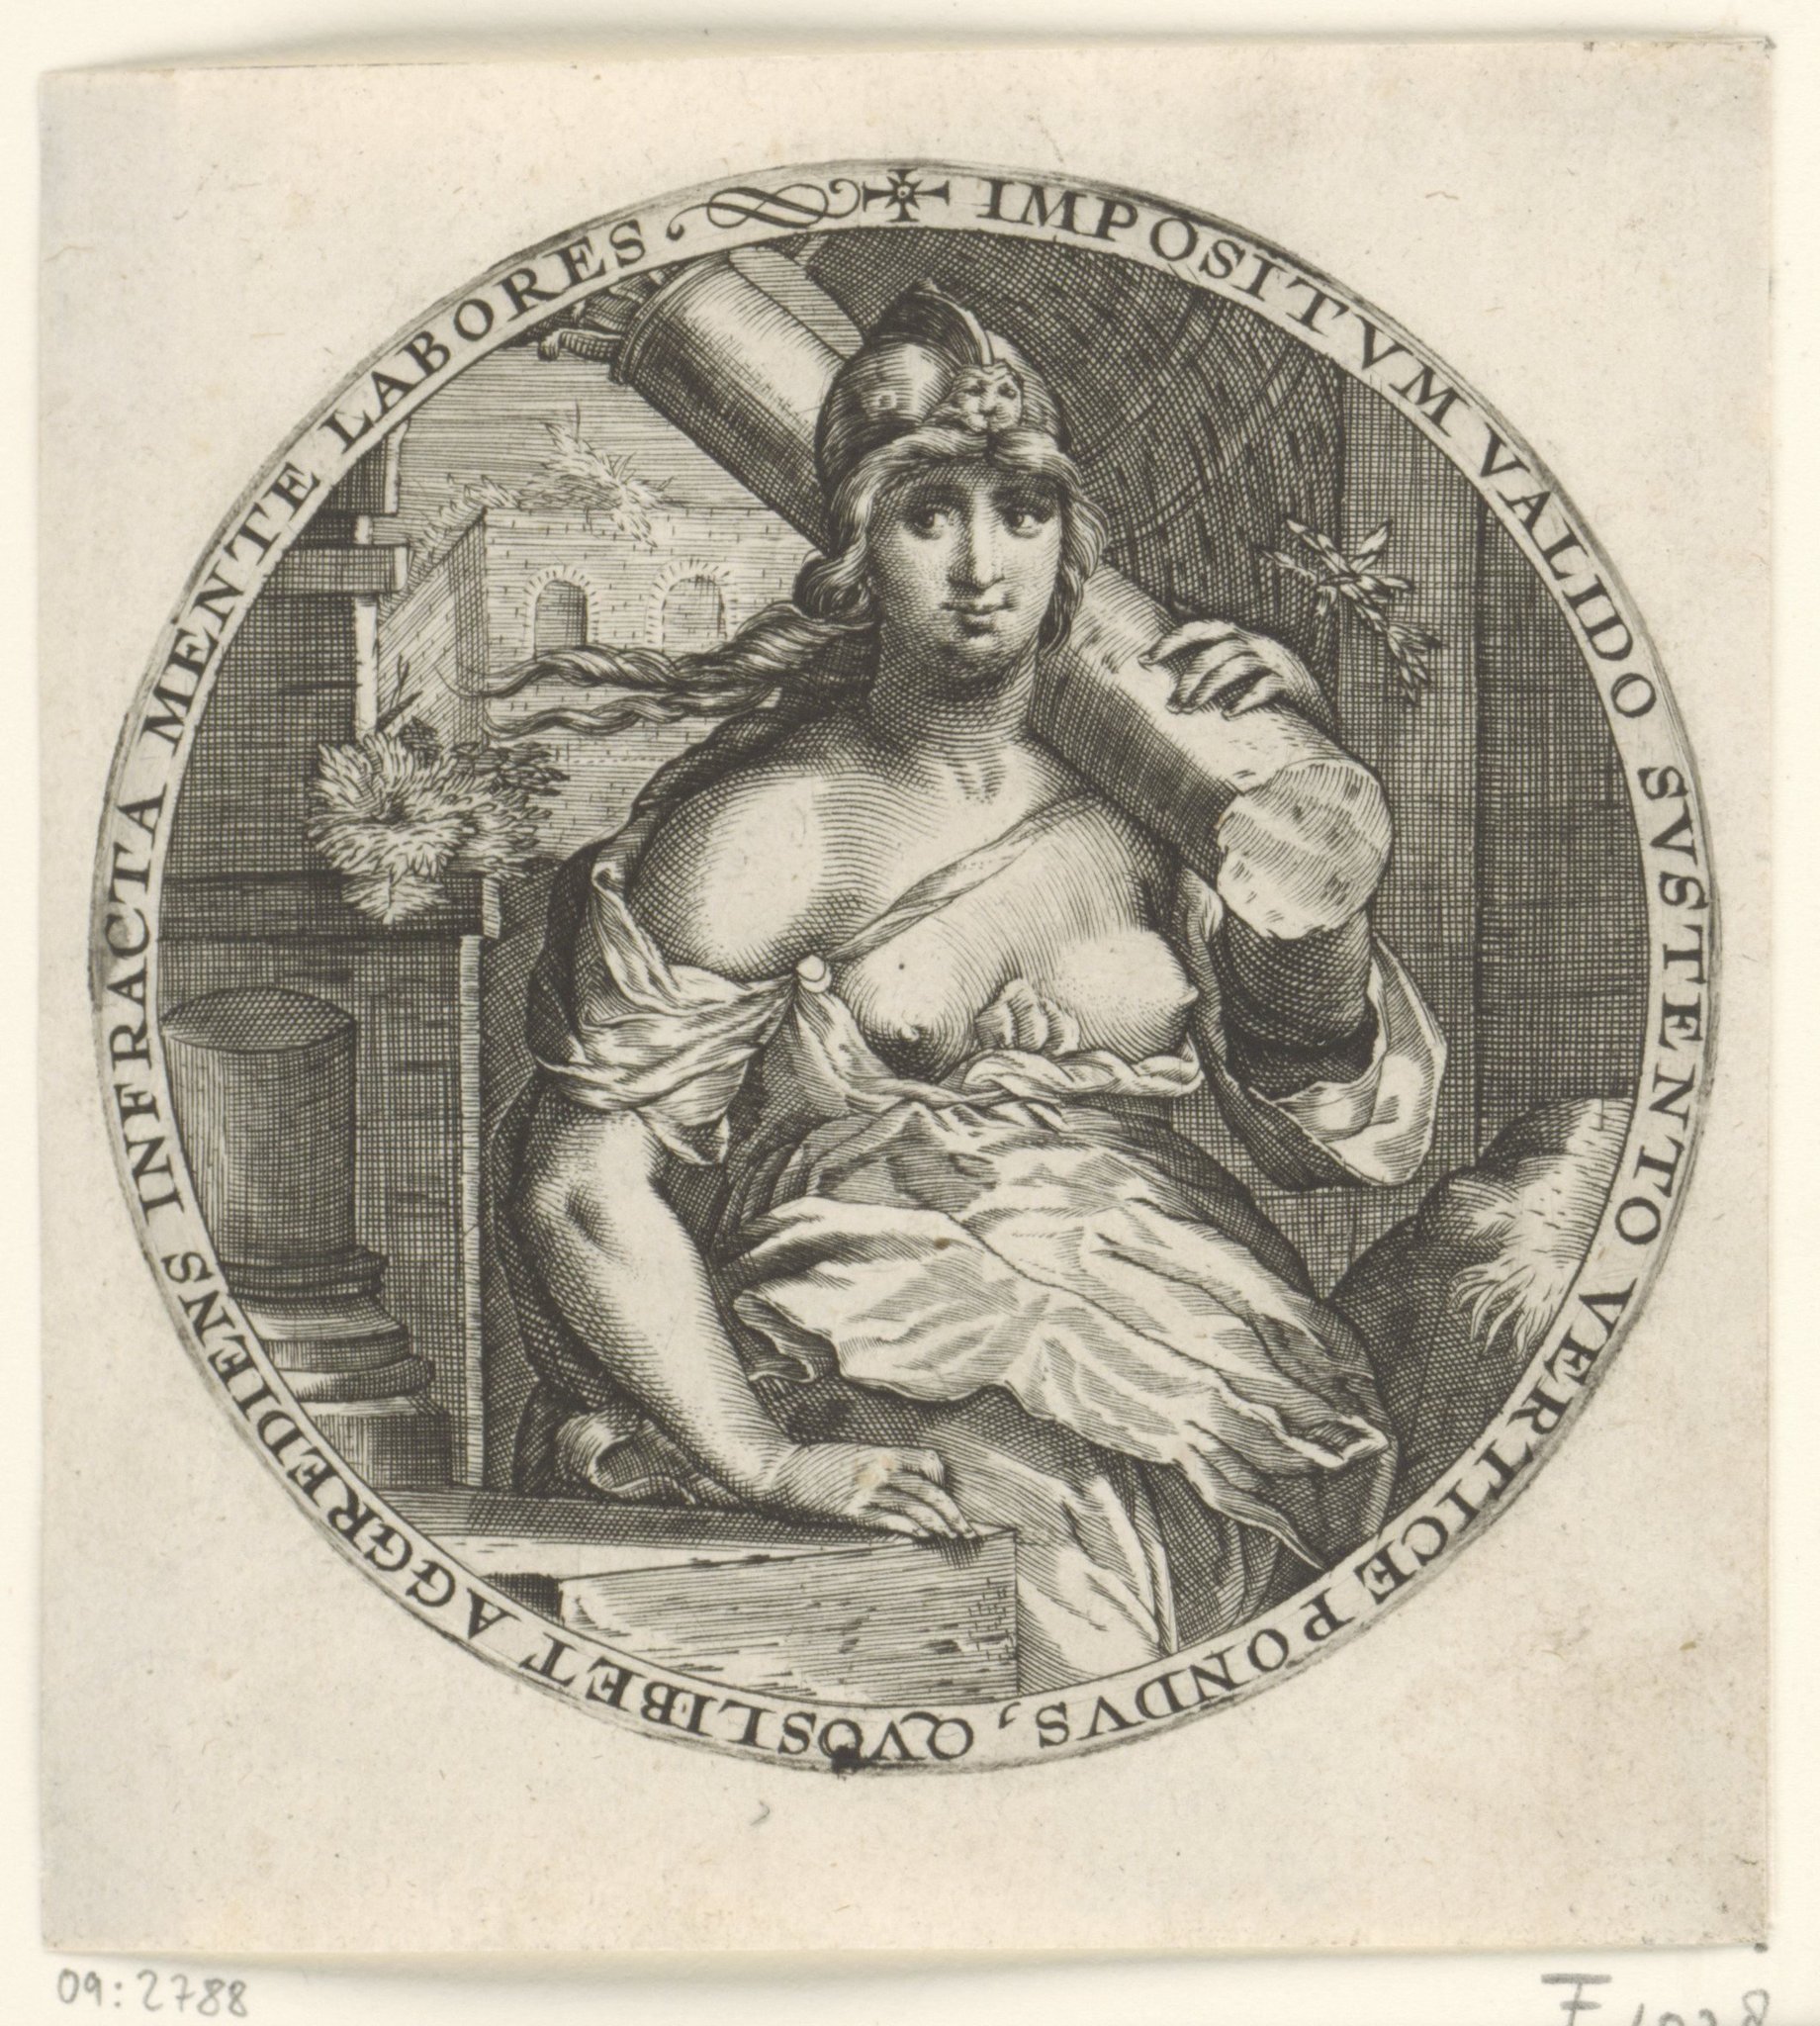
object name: print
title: Virtutu Theologicaru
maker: crispijn van de passe (i)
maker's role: draughtsman, print maker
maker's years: 1564-1637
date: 1600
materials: paper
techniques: engraving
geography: cologne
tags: fortitude, 'fortitudo' ~ one of the four cardinal virtues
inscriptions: collector's mark: Lugt 2228, collector's mark: Lugt 2773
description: De vrouwelijke personificatie van Kracht (Fortitudo), een van de vier kardinale deugden, met een helm. Op haar schouder houdt ze een gebroken zuil. Prent uit een serie met theologische deugden.